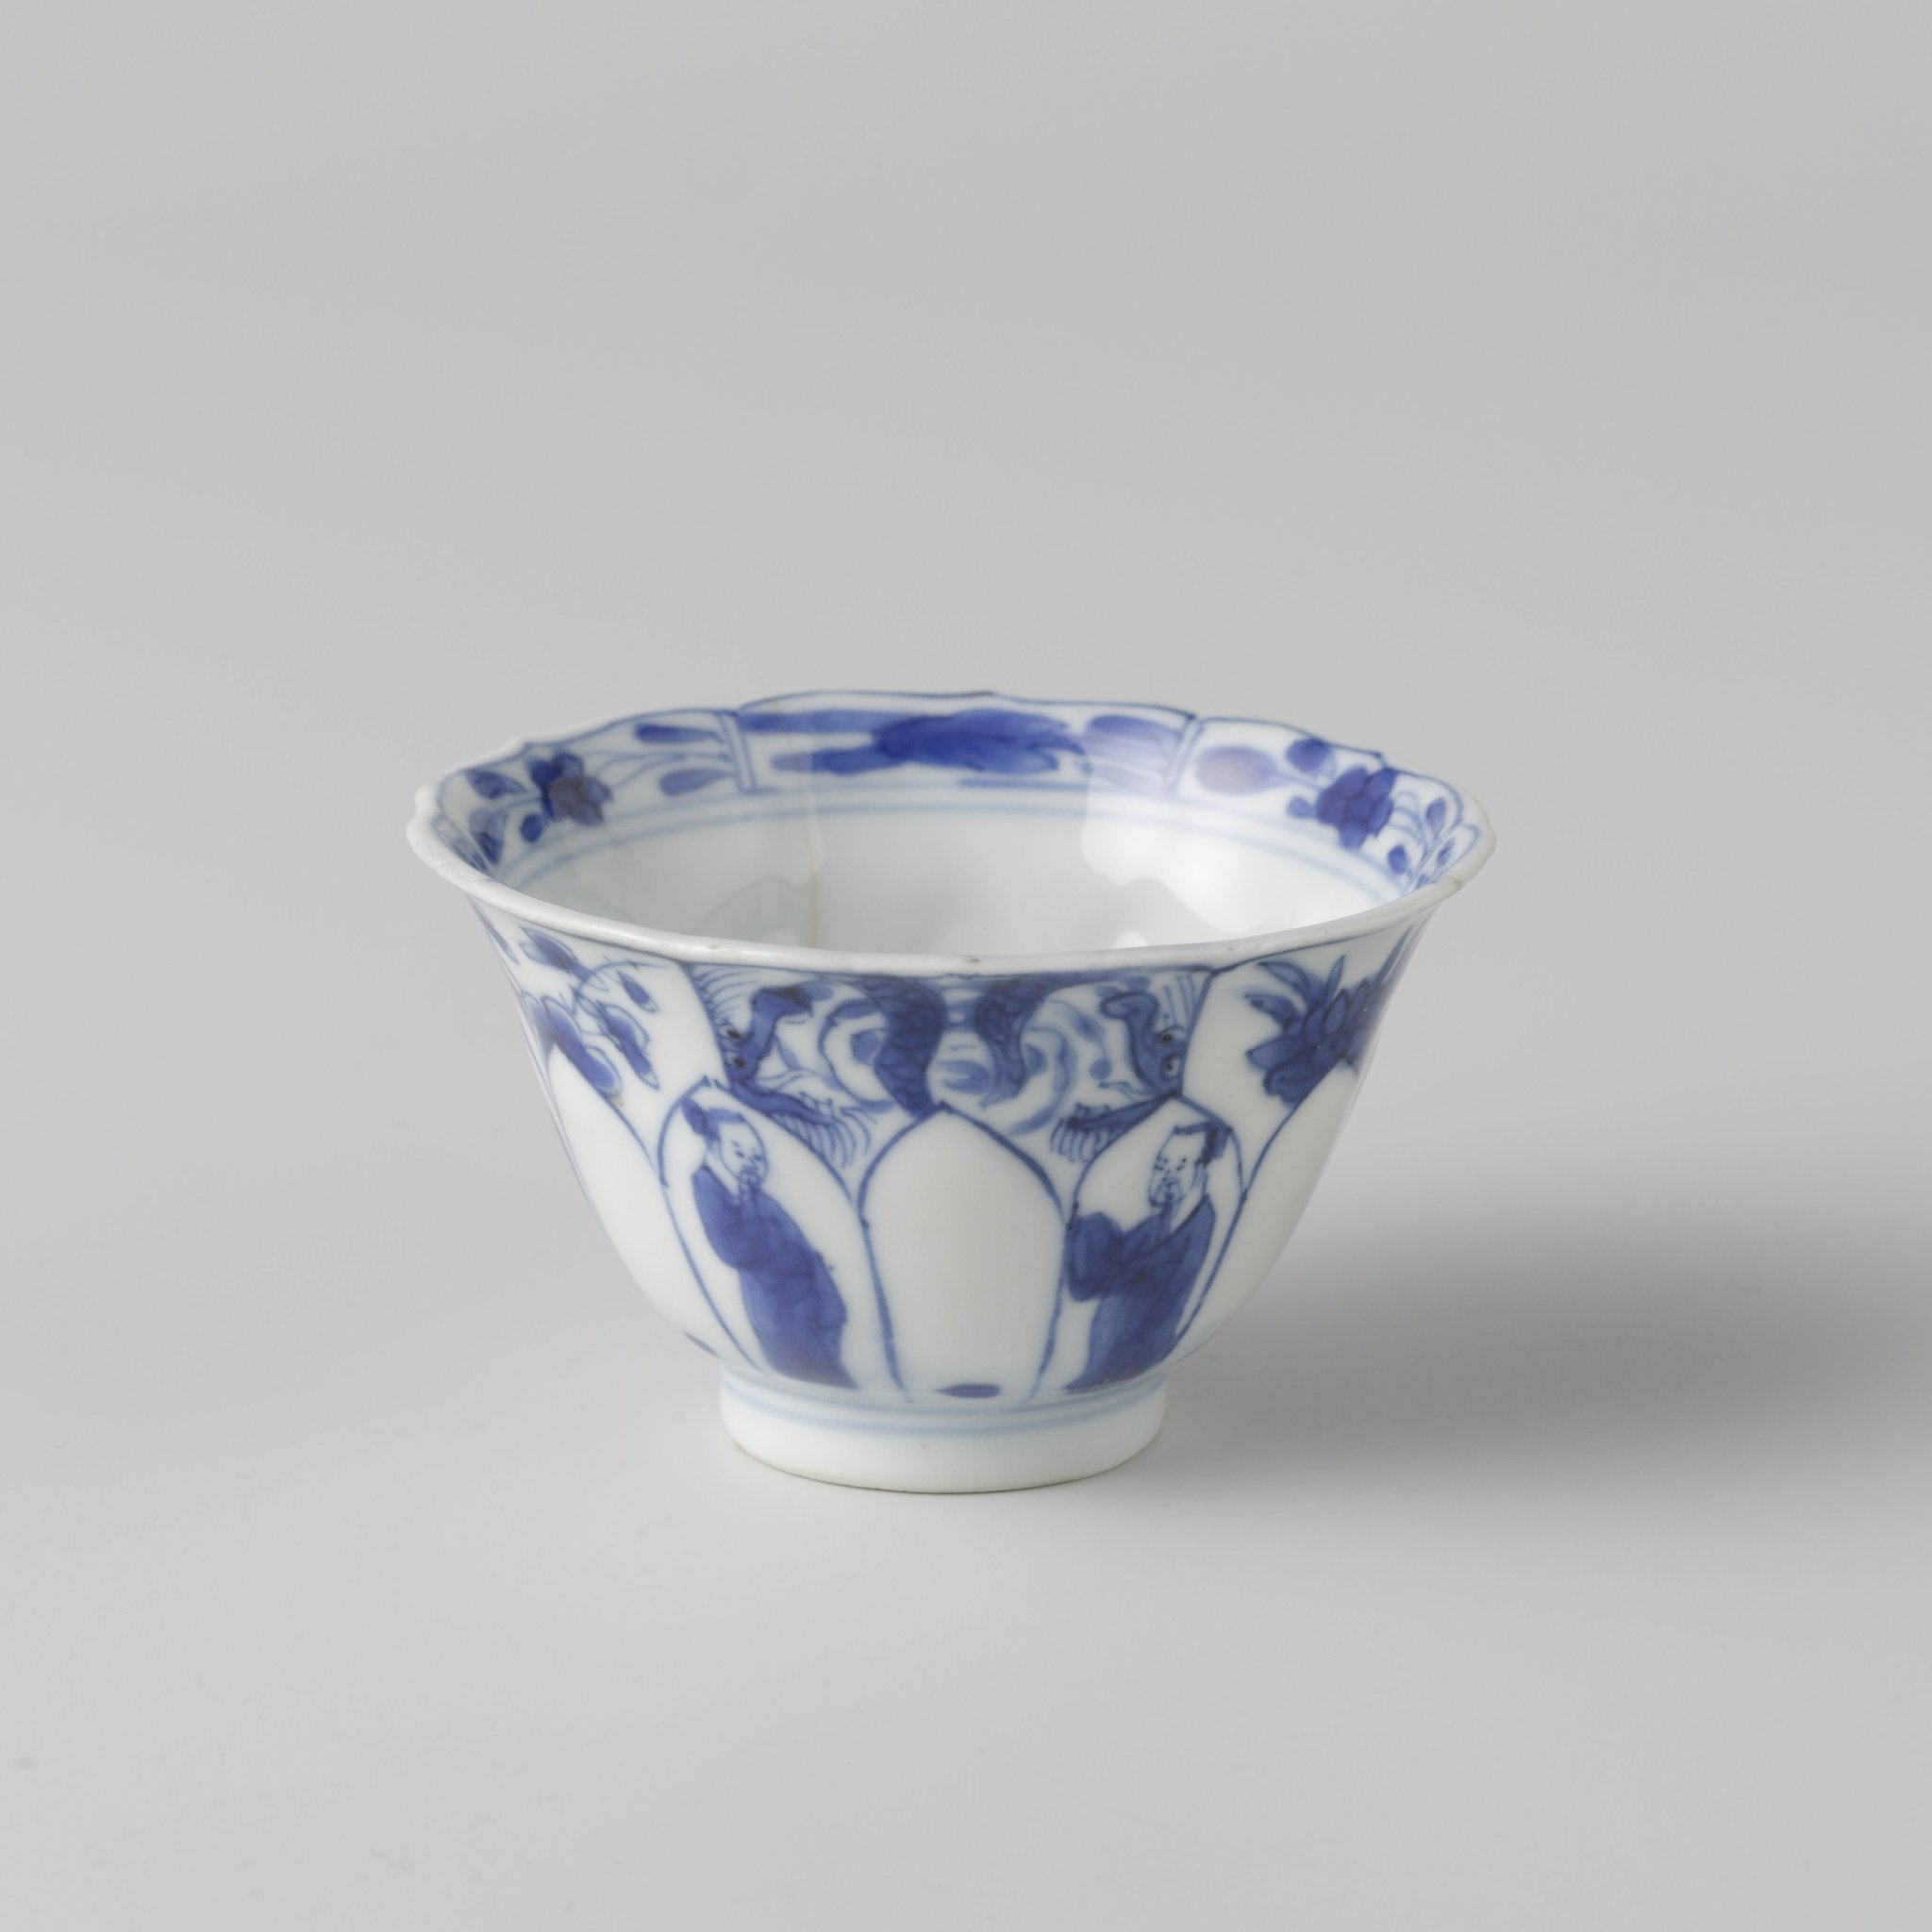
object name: cup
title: Bell-shaped cup with Chinese figures, dragons and flower sprays and the bottom moulded in the shape of flower petals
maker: Anonymous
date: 1680-1720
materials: cobalt, glaze, paint, porcelain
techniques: firing, forming, turning, vitrification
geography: china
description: AK-NM-6880 en 6881 Kop en schotel • Blauw-wit Kangxi-porselein • Onderdeel van Royers porseleincollectie • Oorspronkelijk drie koppen en vijf schotels (inventaris Van der Kellen 1876) Voor de grote aantallen theegoed in Nederland en in de collectie Royer, zie de toelichting bij AK-NM-6895 en -6896.